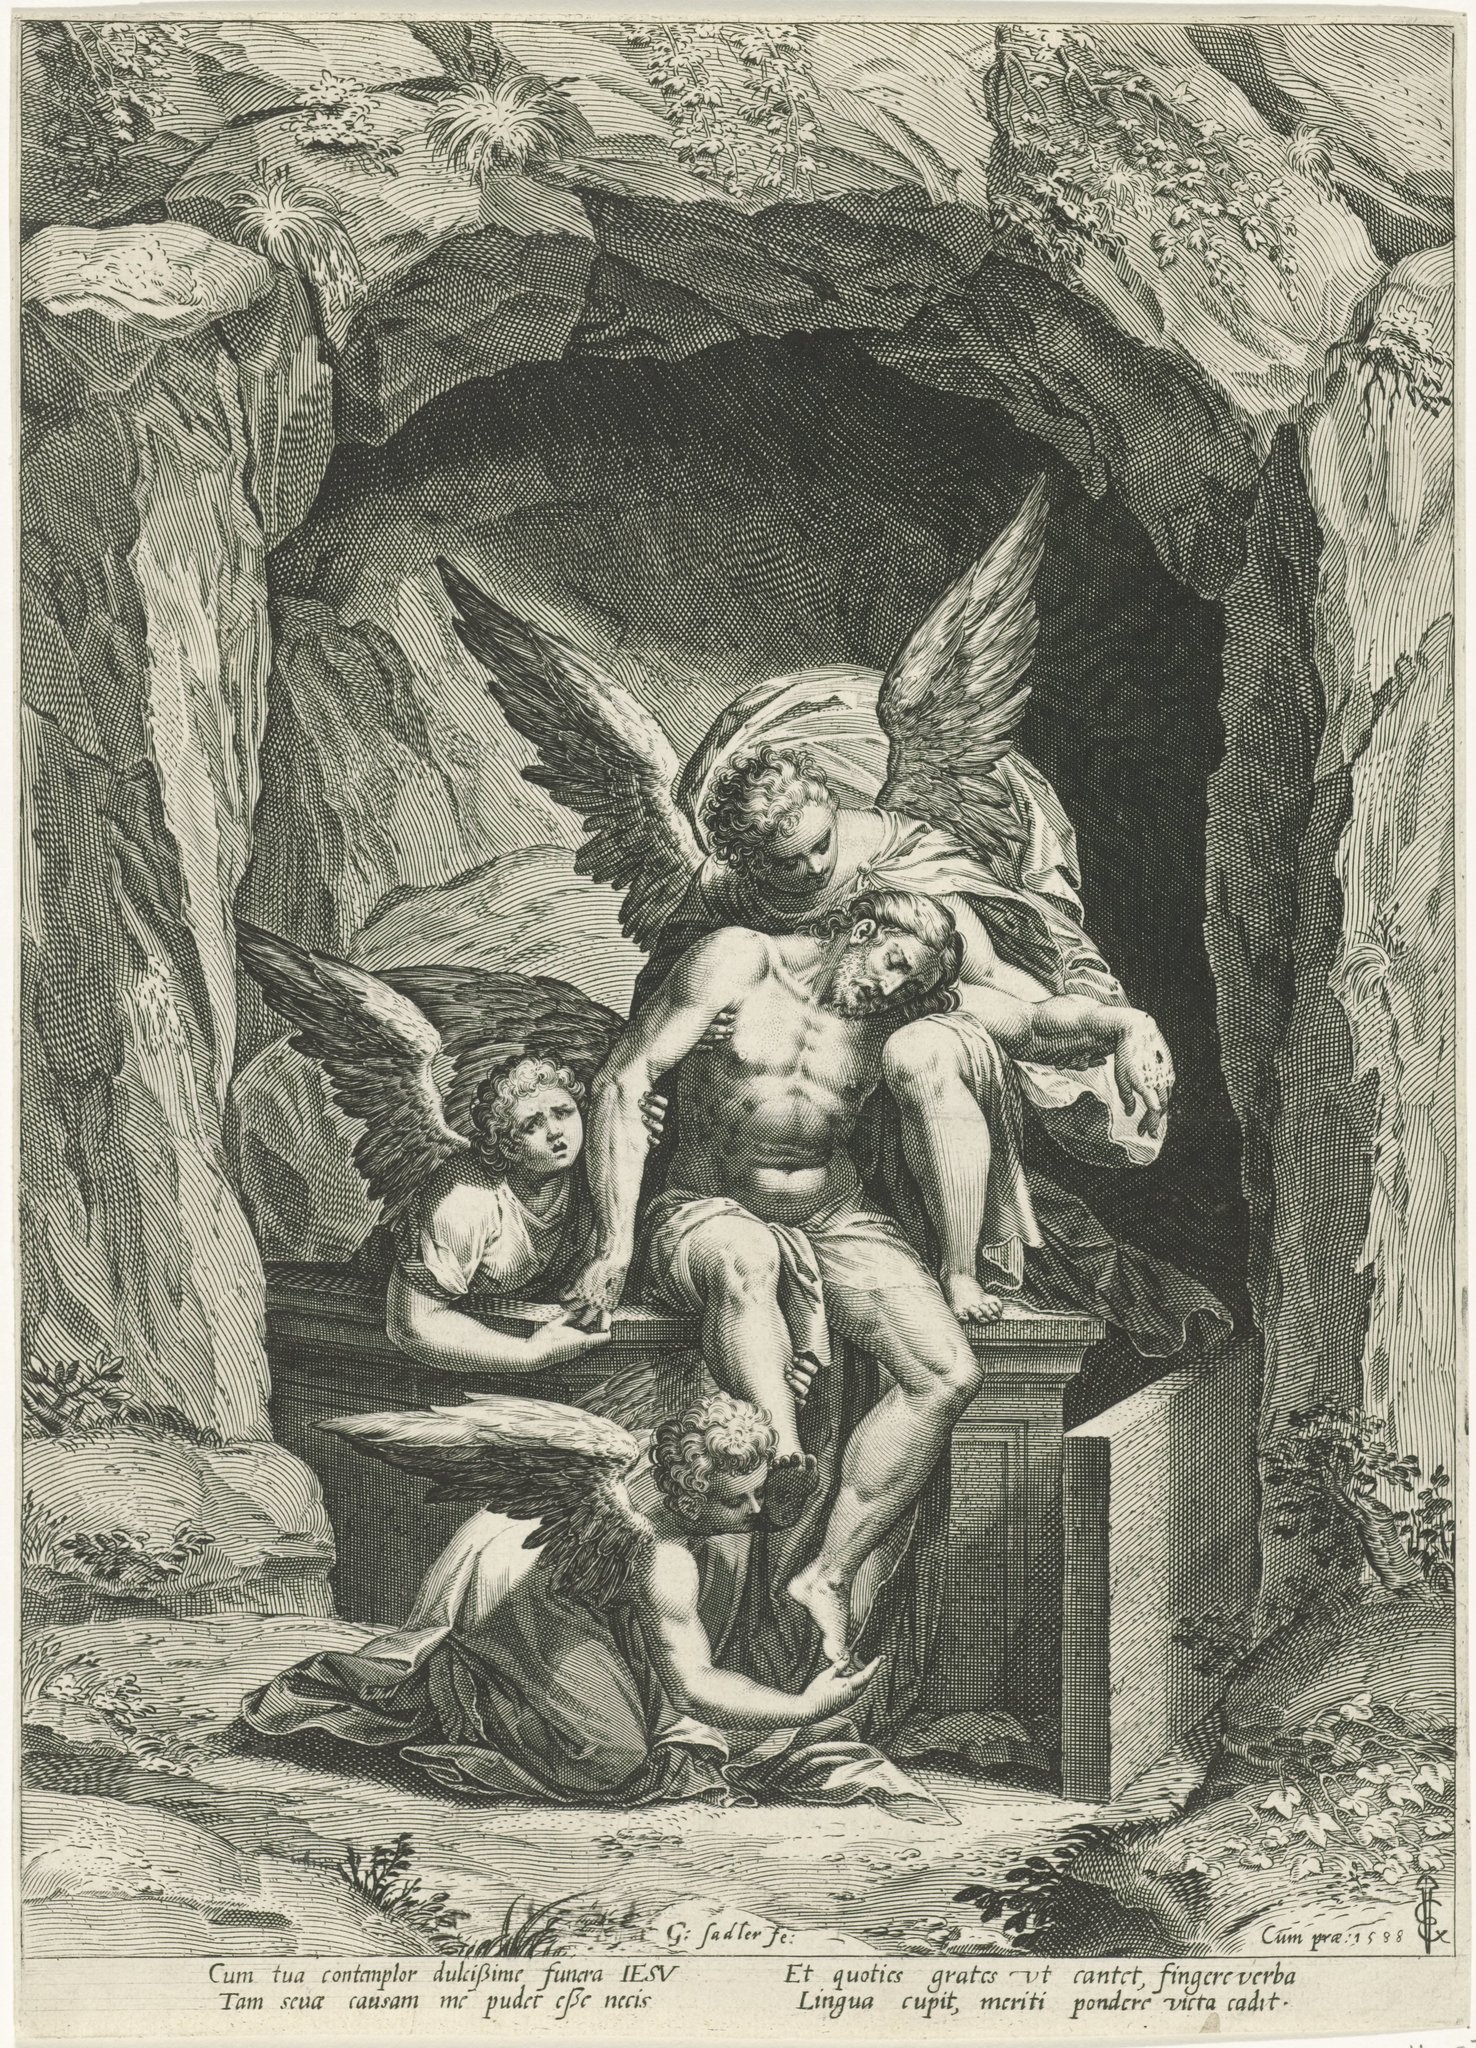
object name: print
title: Graflegging van Christus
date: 1588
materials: paper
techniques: engraving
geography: antwerp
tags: christ's entombment (possibly by angels) (+ angel(s))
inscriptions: collector's mark: Lugt 240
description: Het lichaam van Christus wordt door drie engelen in het graf gelegd. De prent heeft een Latijns onderschrift.